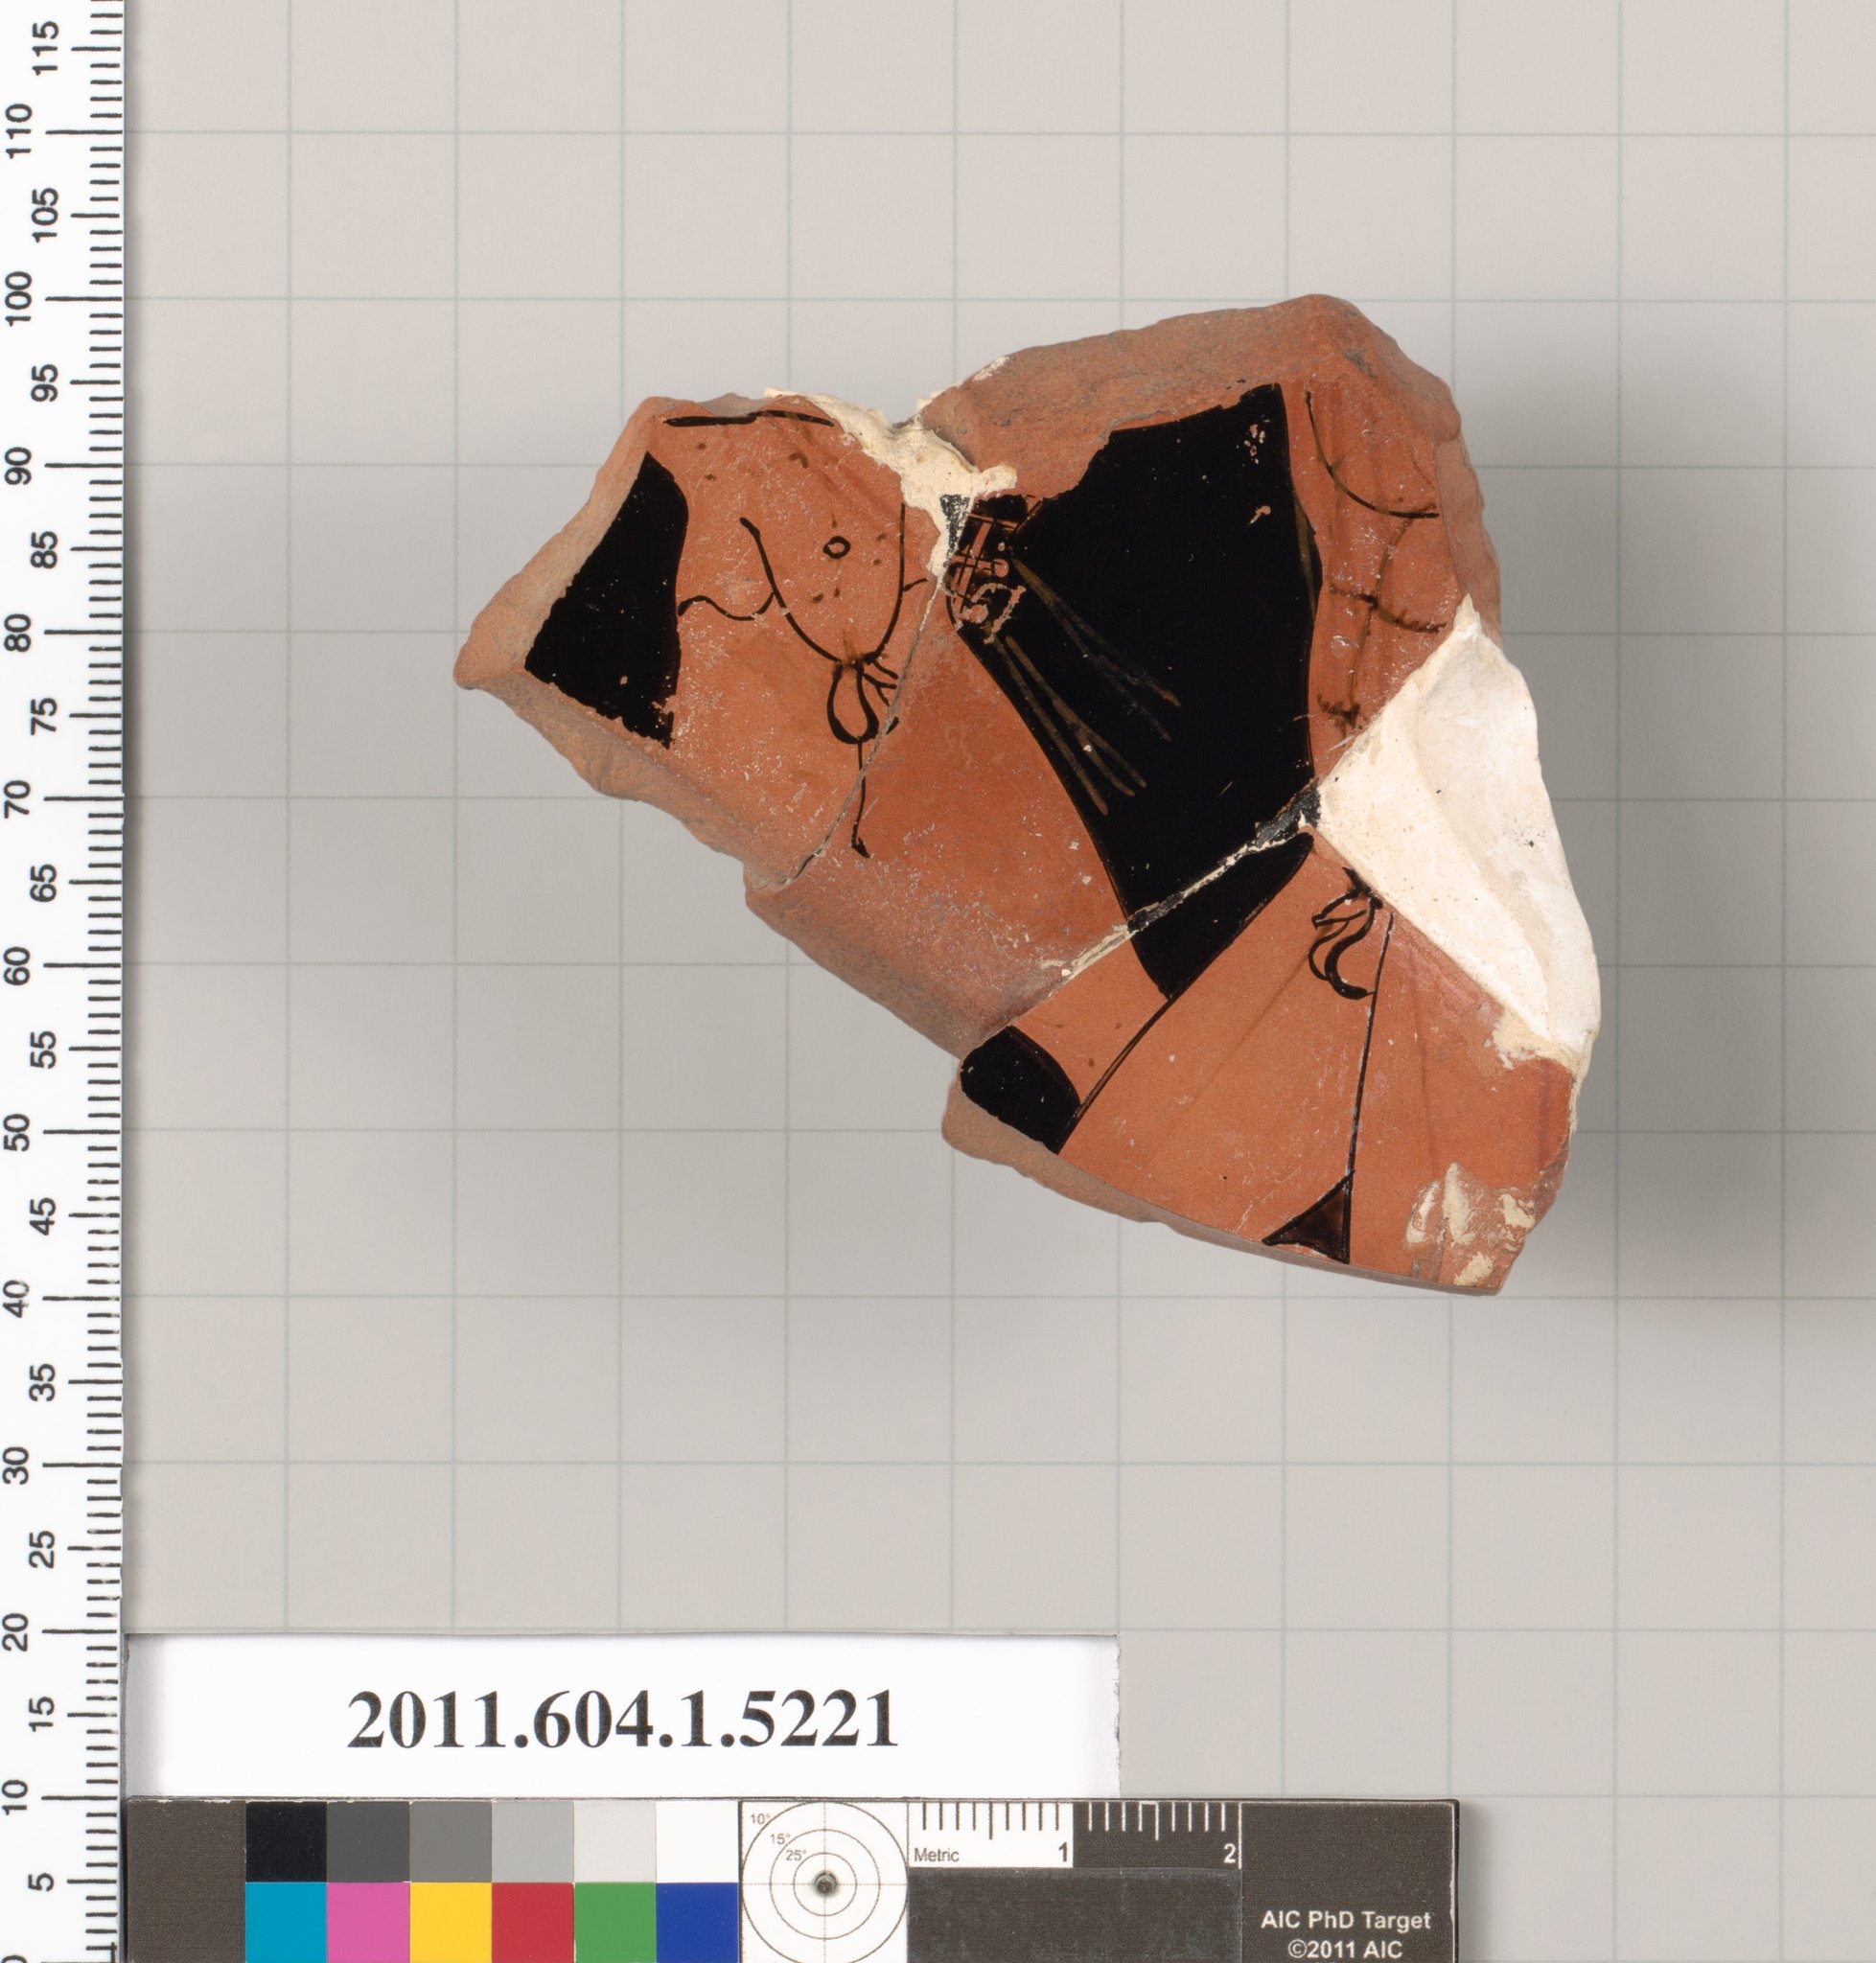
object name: kylix fragment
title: Terracotta fragment of a kylix (drinking cup)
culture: greek, attic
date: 490-470 BCE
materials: terracotta